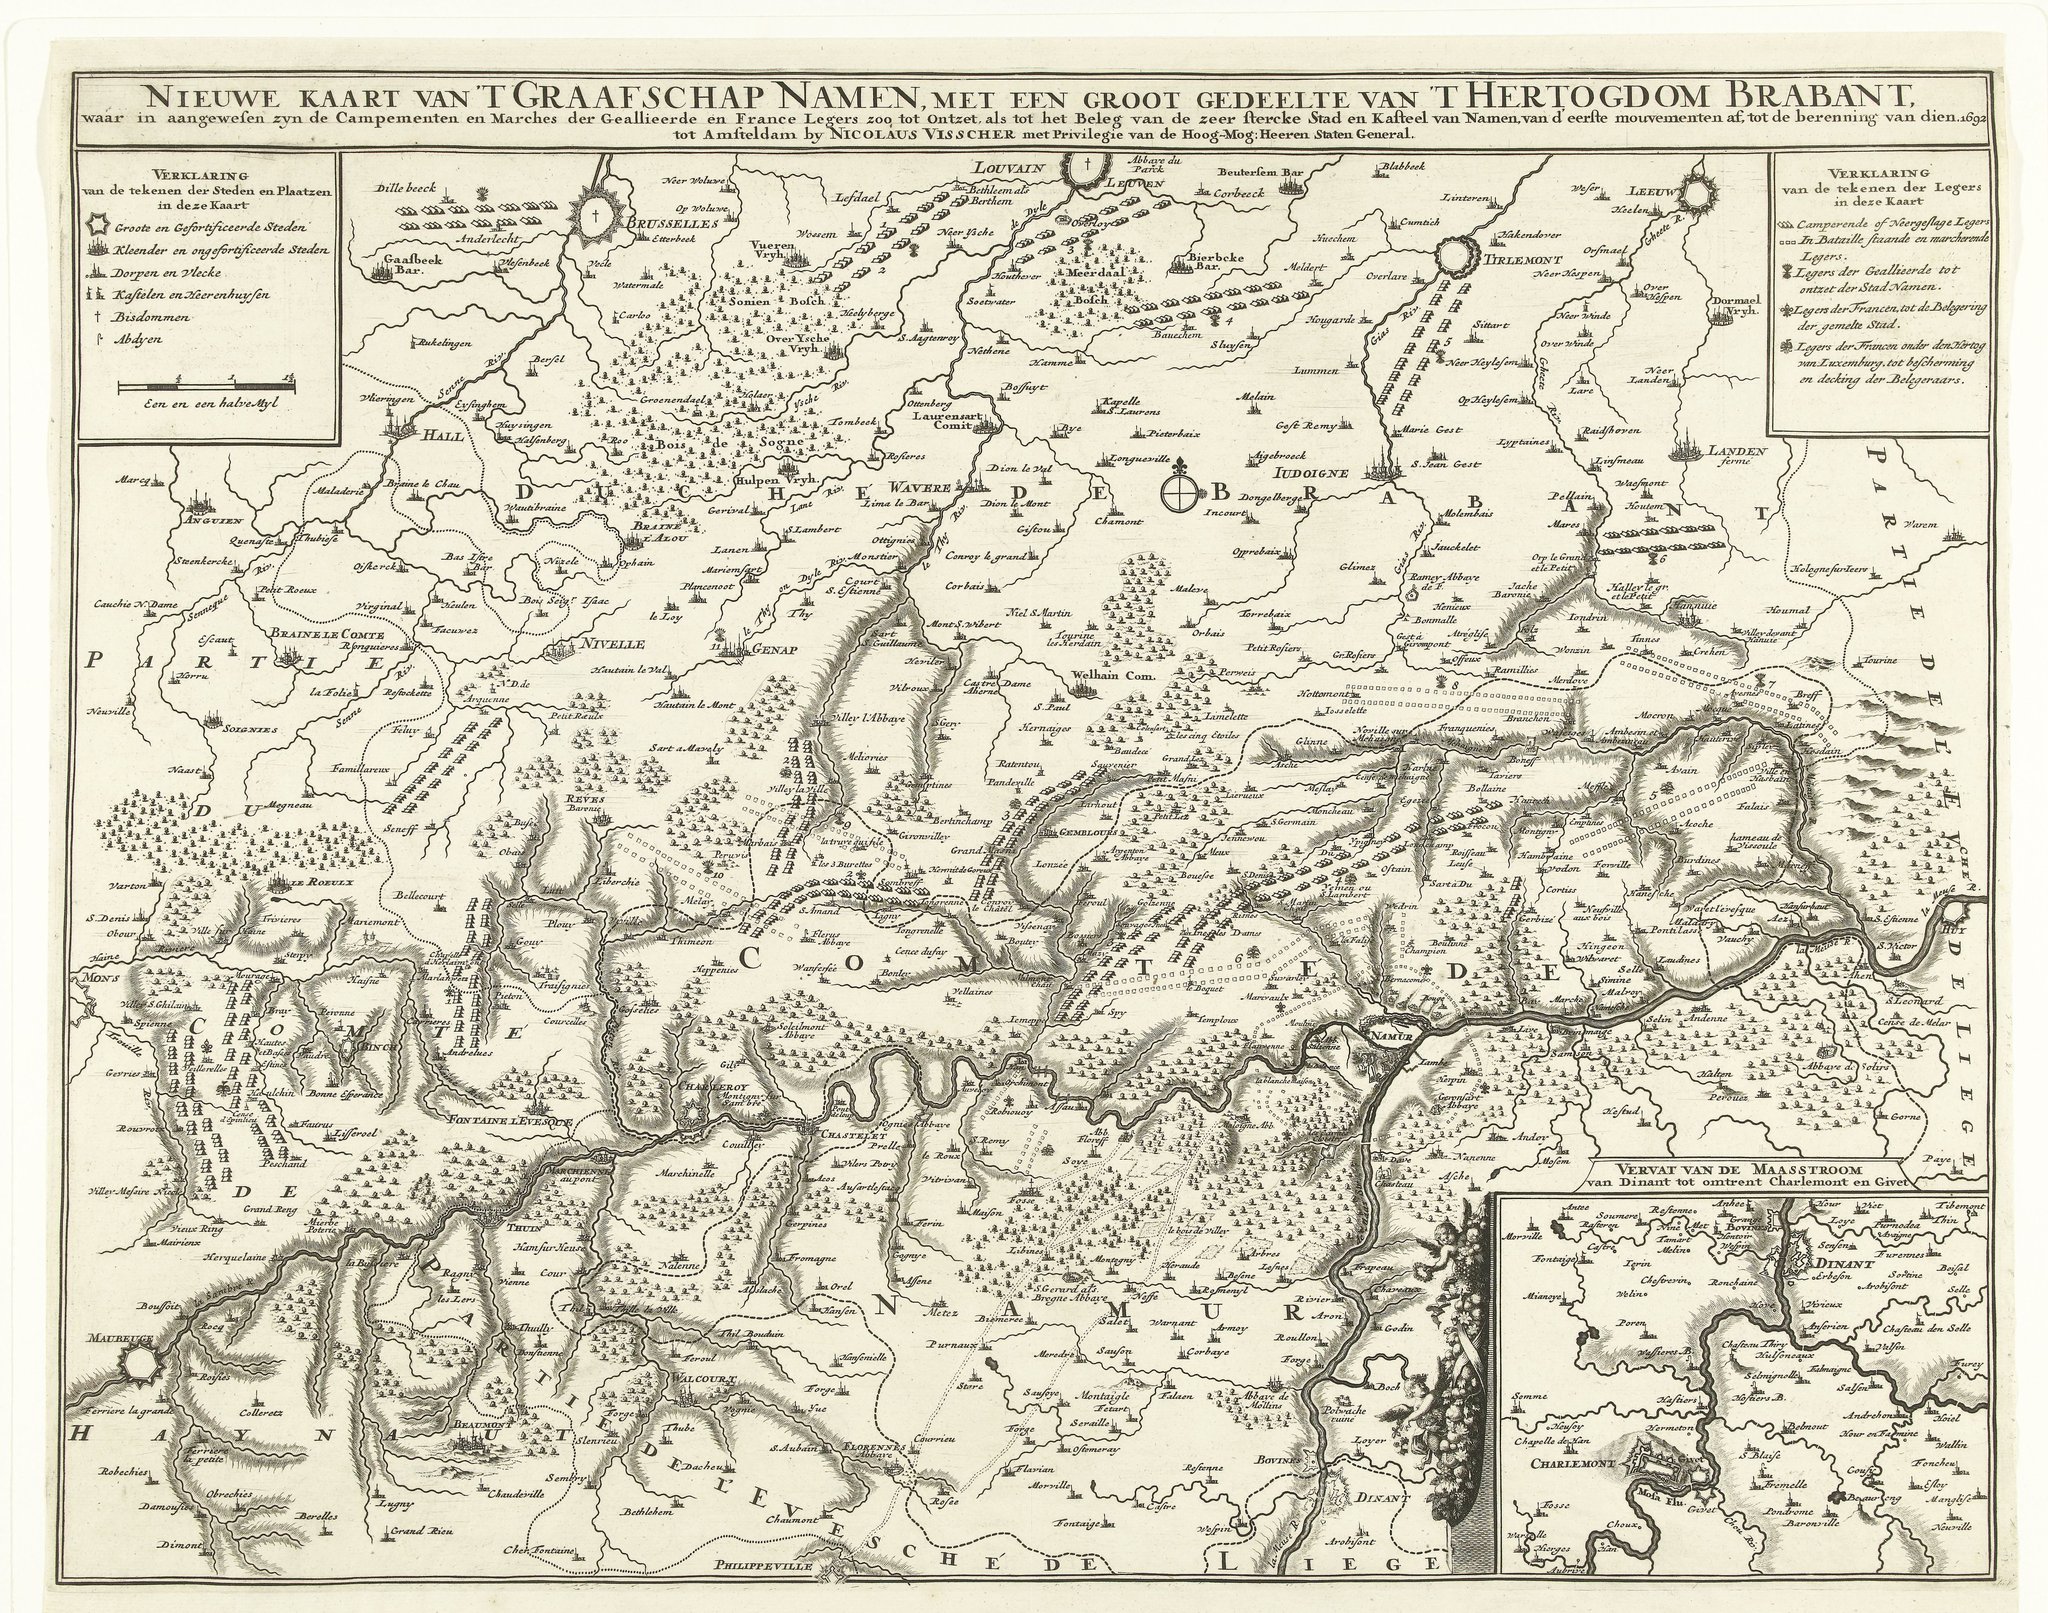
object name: print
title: Kaart van het graafschap Namen met de posities van de Geallieerde en Franse legers, 1692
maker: Anonymous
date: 1692-1720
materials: paper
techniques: engraving, etching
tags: maps of separate countries or regions, namur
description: Kaart van het graafschap Namen waarop de posities van de Geallieerde en Franse legers zijn aangegeven, 1692. De titel in een balk boven de kaart. Rechtsonder een inzet met een kaart van het loopgebied van de Maas onder Dinant. Linksboven een kader met legenda en onderin een schaalstok: Een en een halve Myl. Rechtsboven nog een legenda.